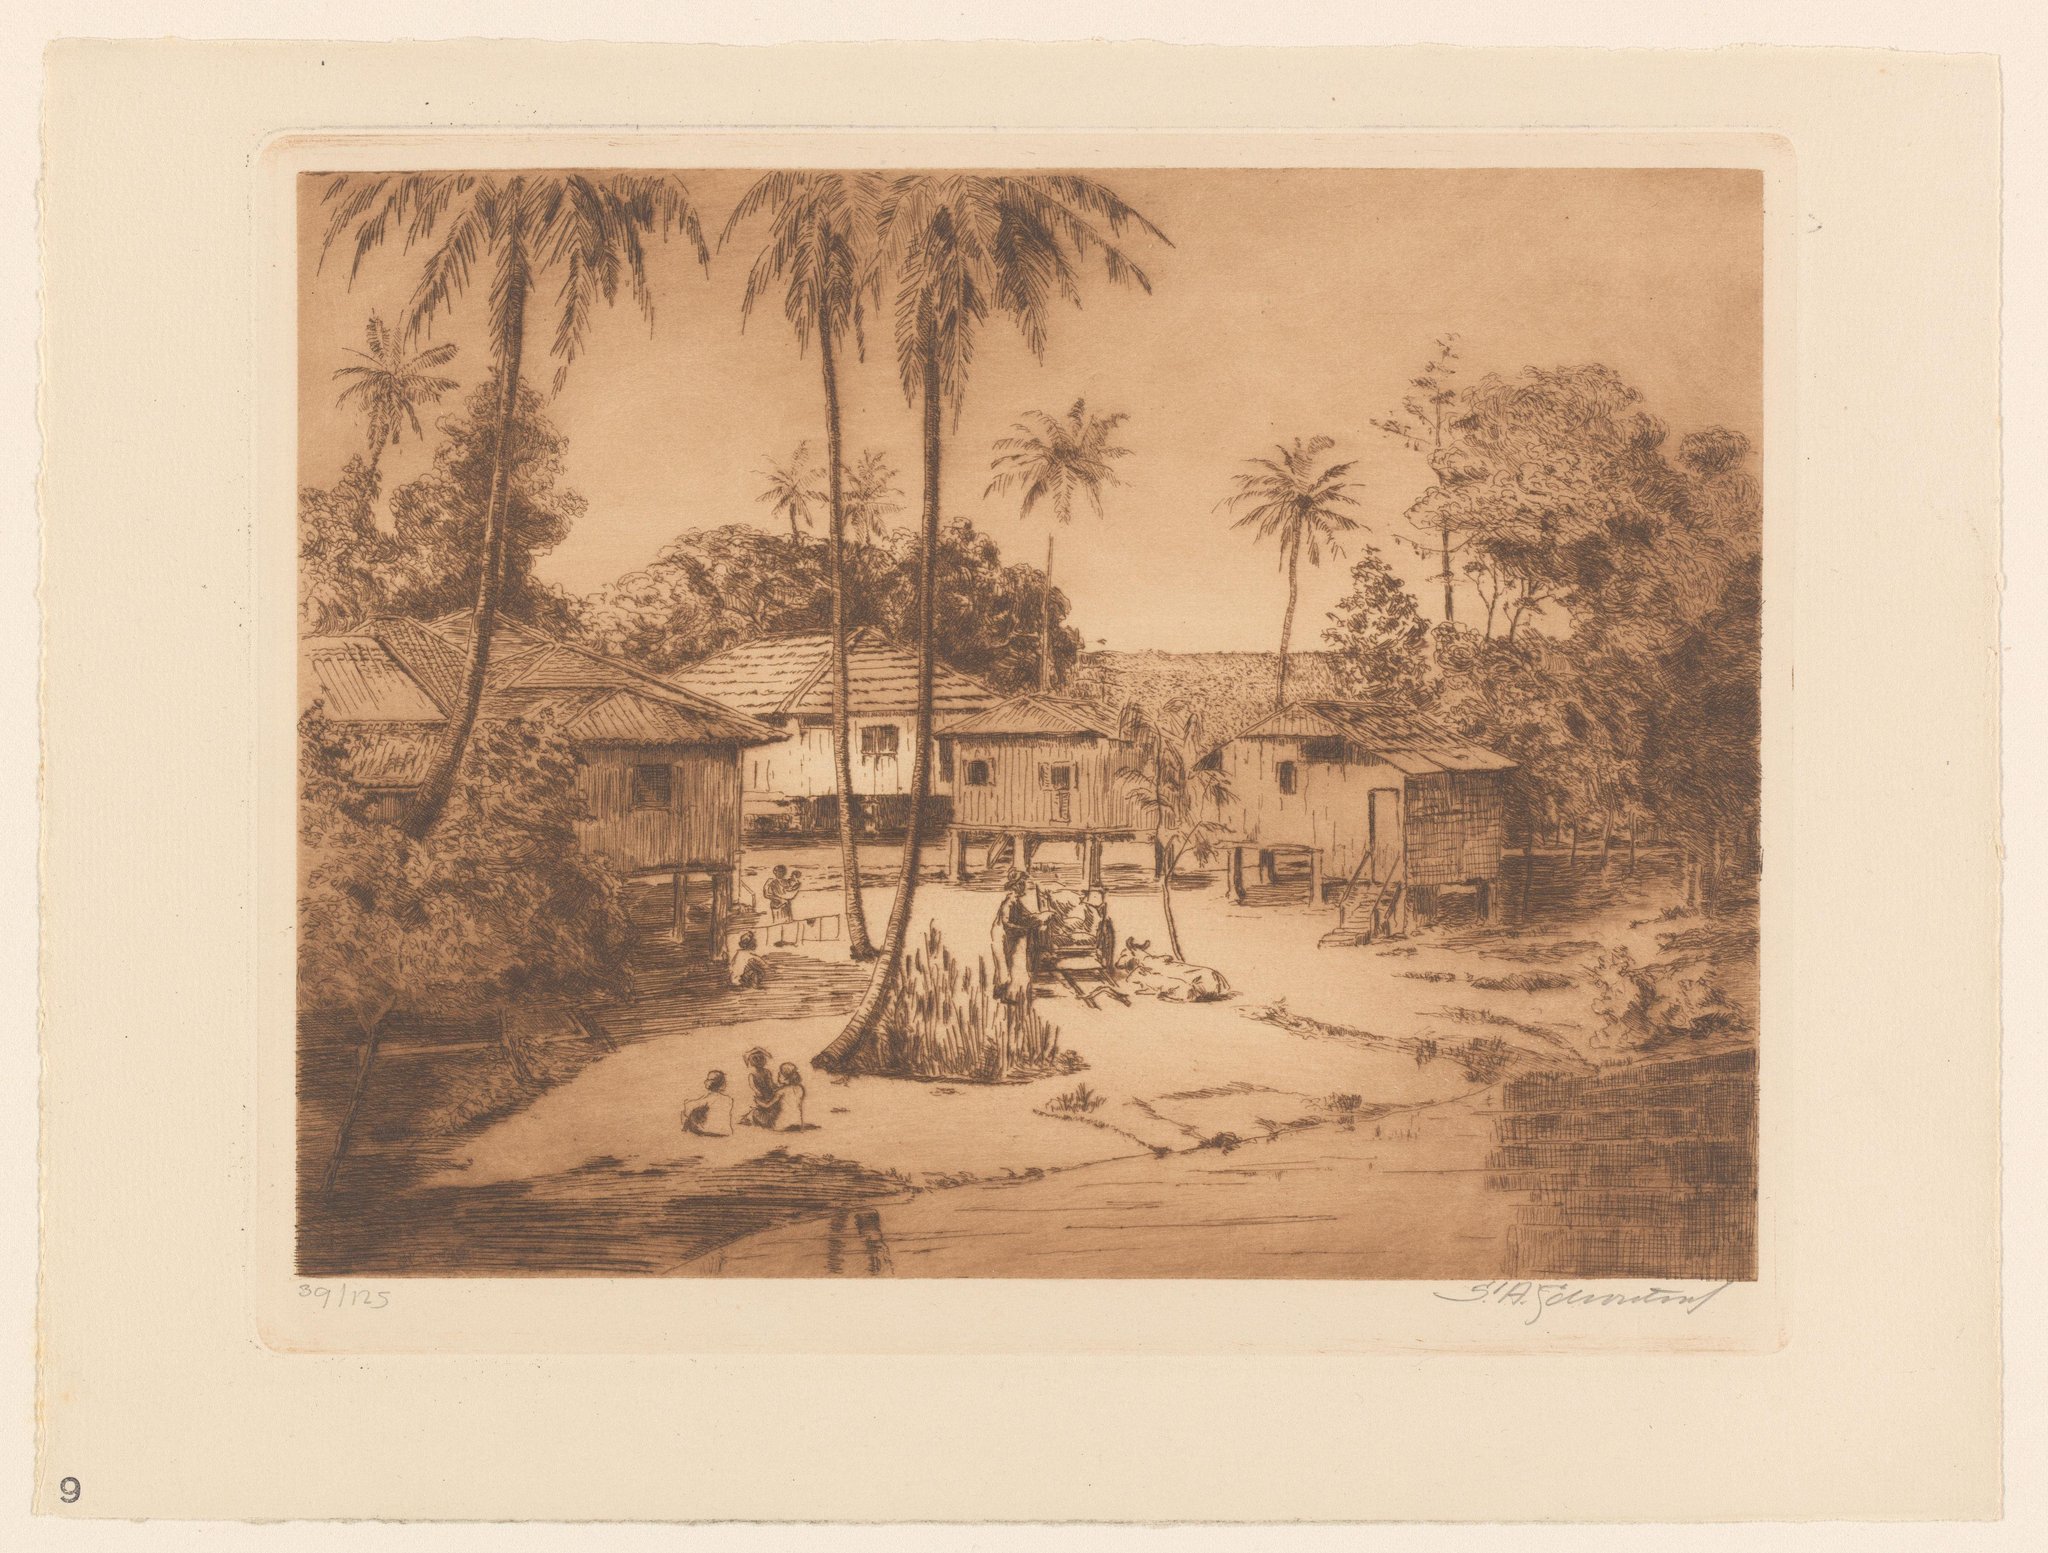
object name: print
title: Gezicht op een kampong in Medan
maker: st. a. schouten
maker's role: print maker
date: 1929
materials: paper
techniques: etching, intaglio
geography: amsterdam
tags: prospect of village, silhouette of village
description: Aangezien geboorte- en sterfdatum van de kunstenaar onbekend zijn, is voor de rechtenbepaling van dit object de productiedatum gehanteerd.